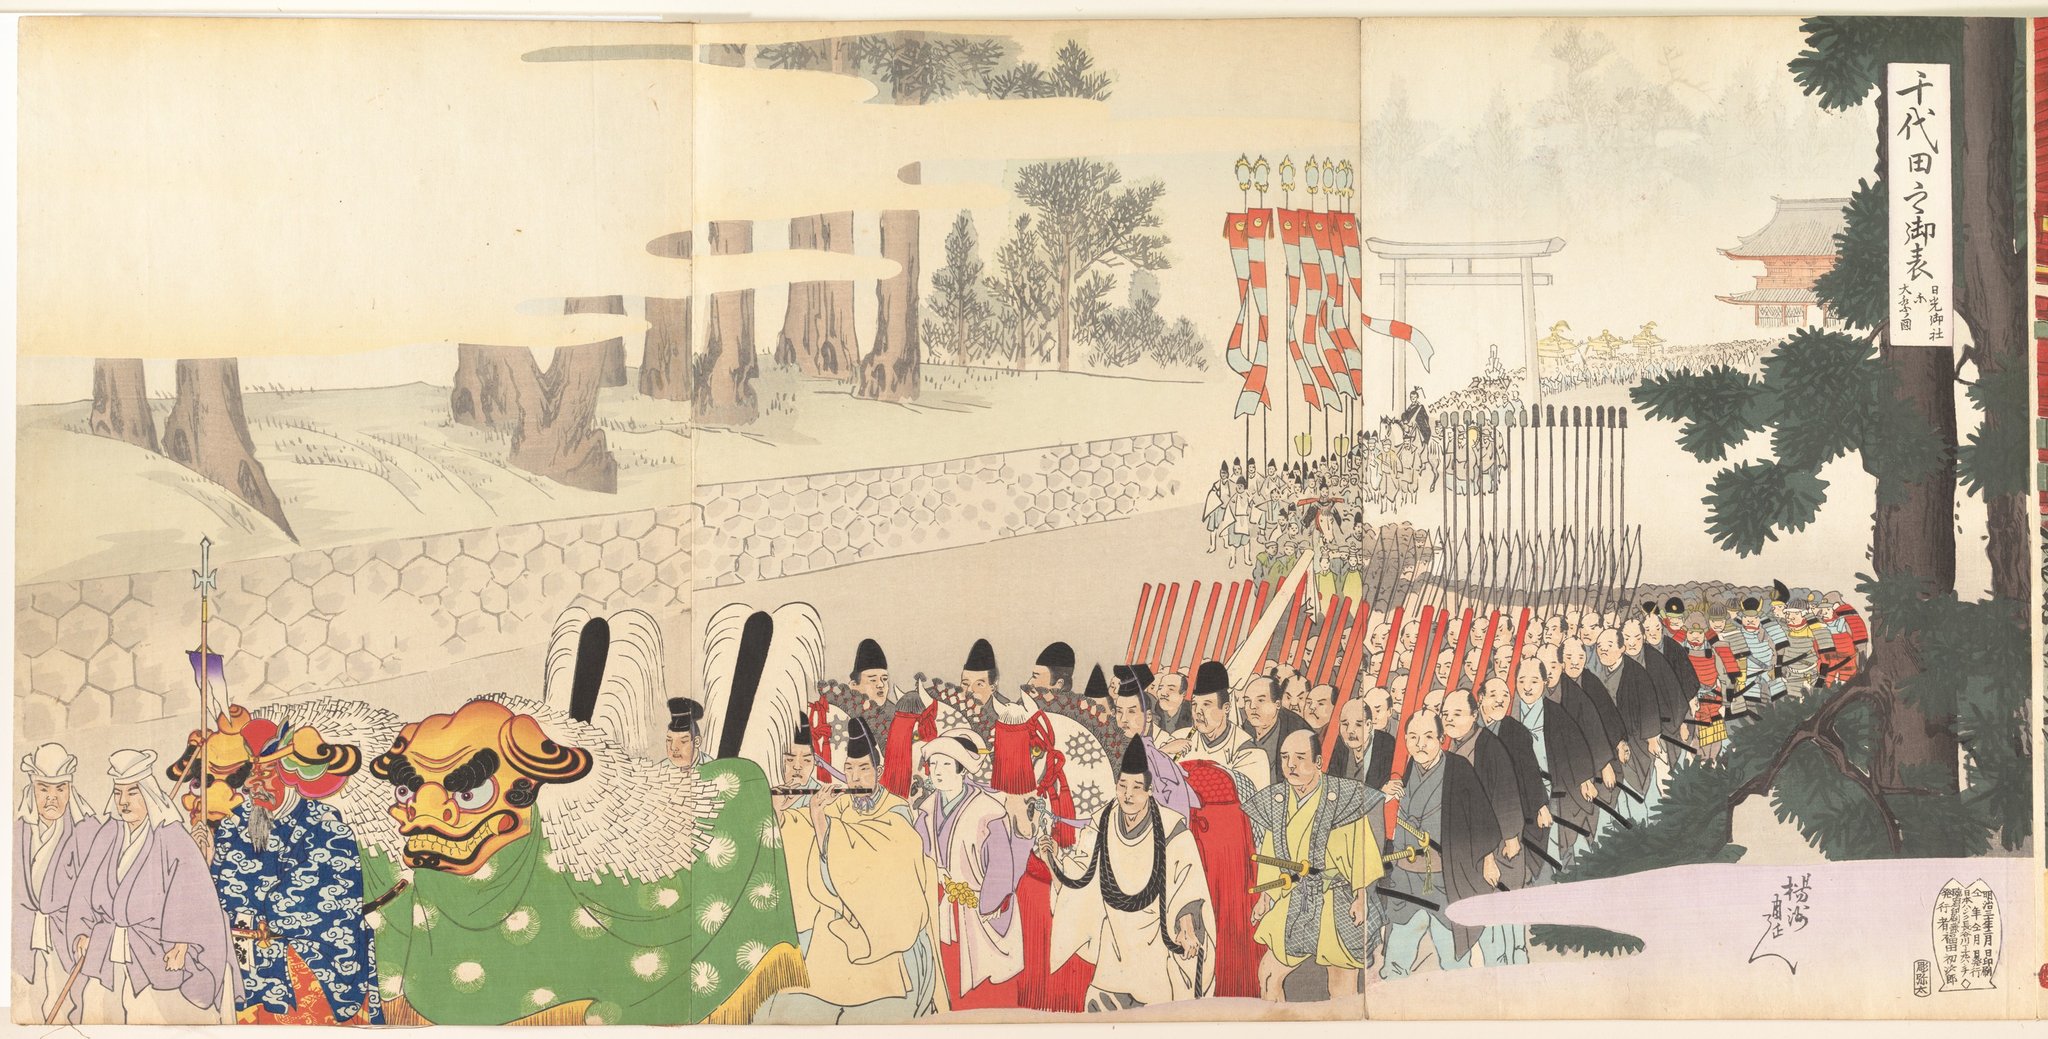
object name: print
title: Chiyoda Castle (Album of Men)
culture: japanese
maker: yōshū (hashimoto) chikanobu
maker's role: artist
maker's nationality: japanese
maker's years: 1838-1912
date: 1897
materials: ink, paper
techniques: woodblock print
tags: men,crowd